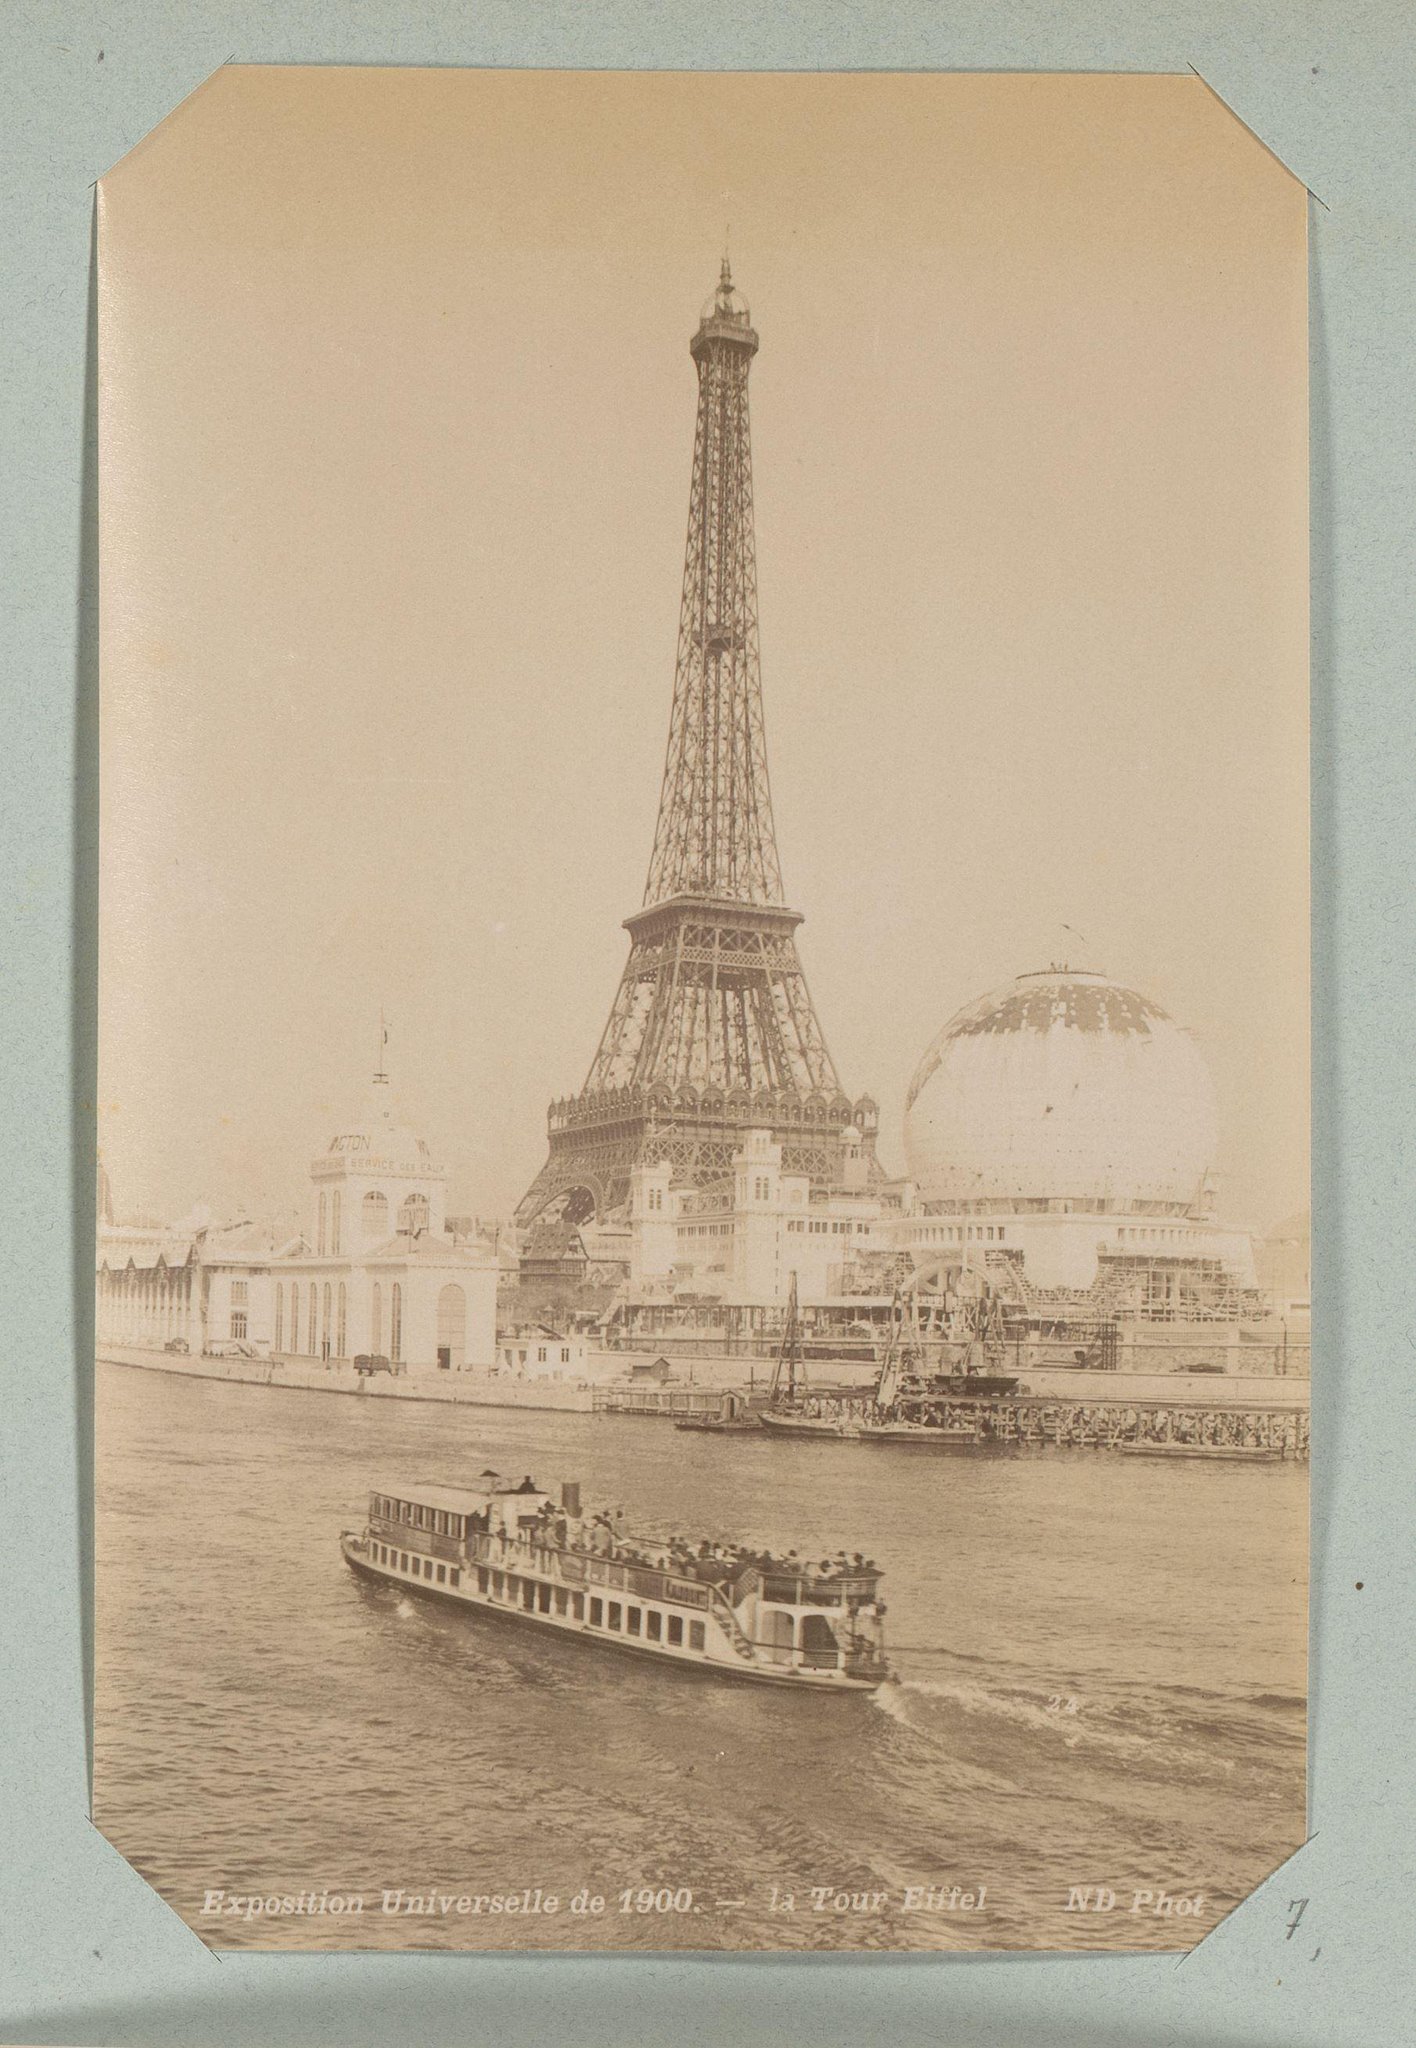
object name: album leaf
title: Exposition Universelle de 1900. La Tour Eiffel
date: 1900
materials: paper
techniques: albumen print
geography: paris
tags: tower, clock tower ~ monumental adornment, world fair, world exhibition, steamship, motorship, paris, eiffel tower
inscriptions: inscription: ‘ND Phot’, number: ‘24’, inscription: ‘10 Aug-25 Aug. 1900’